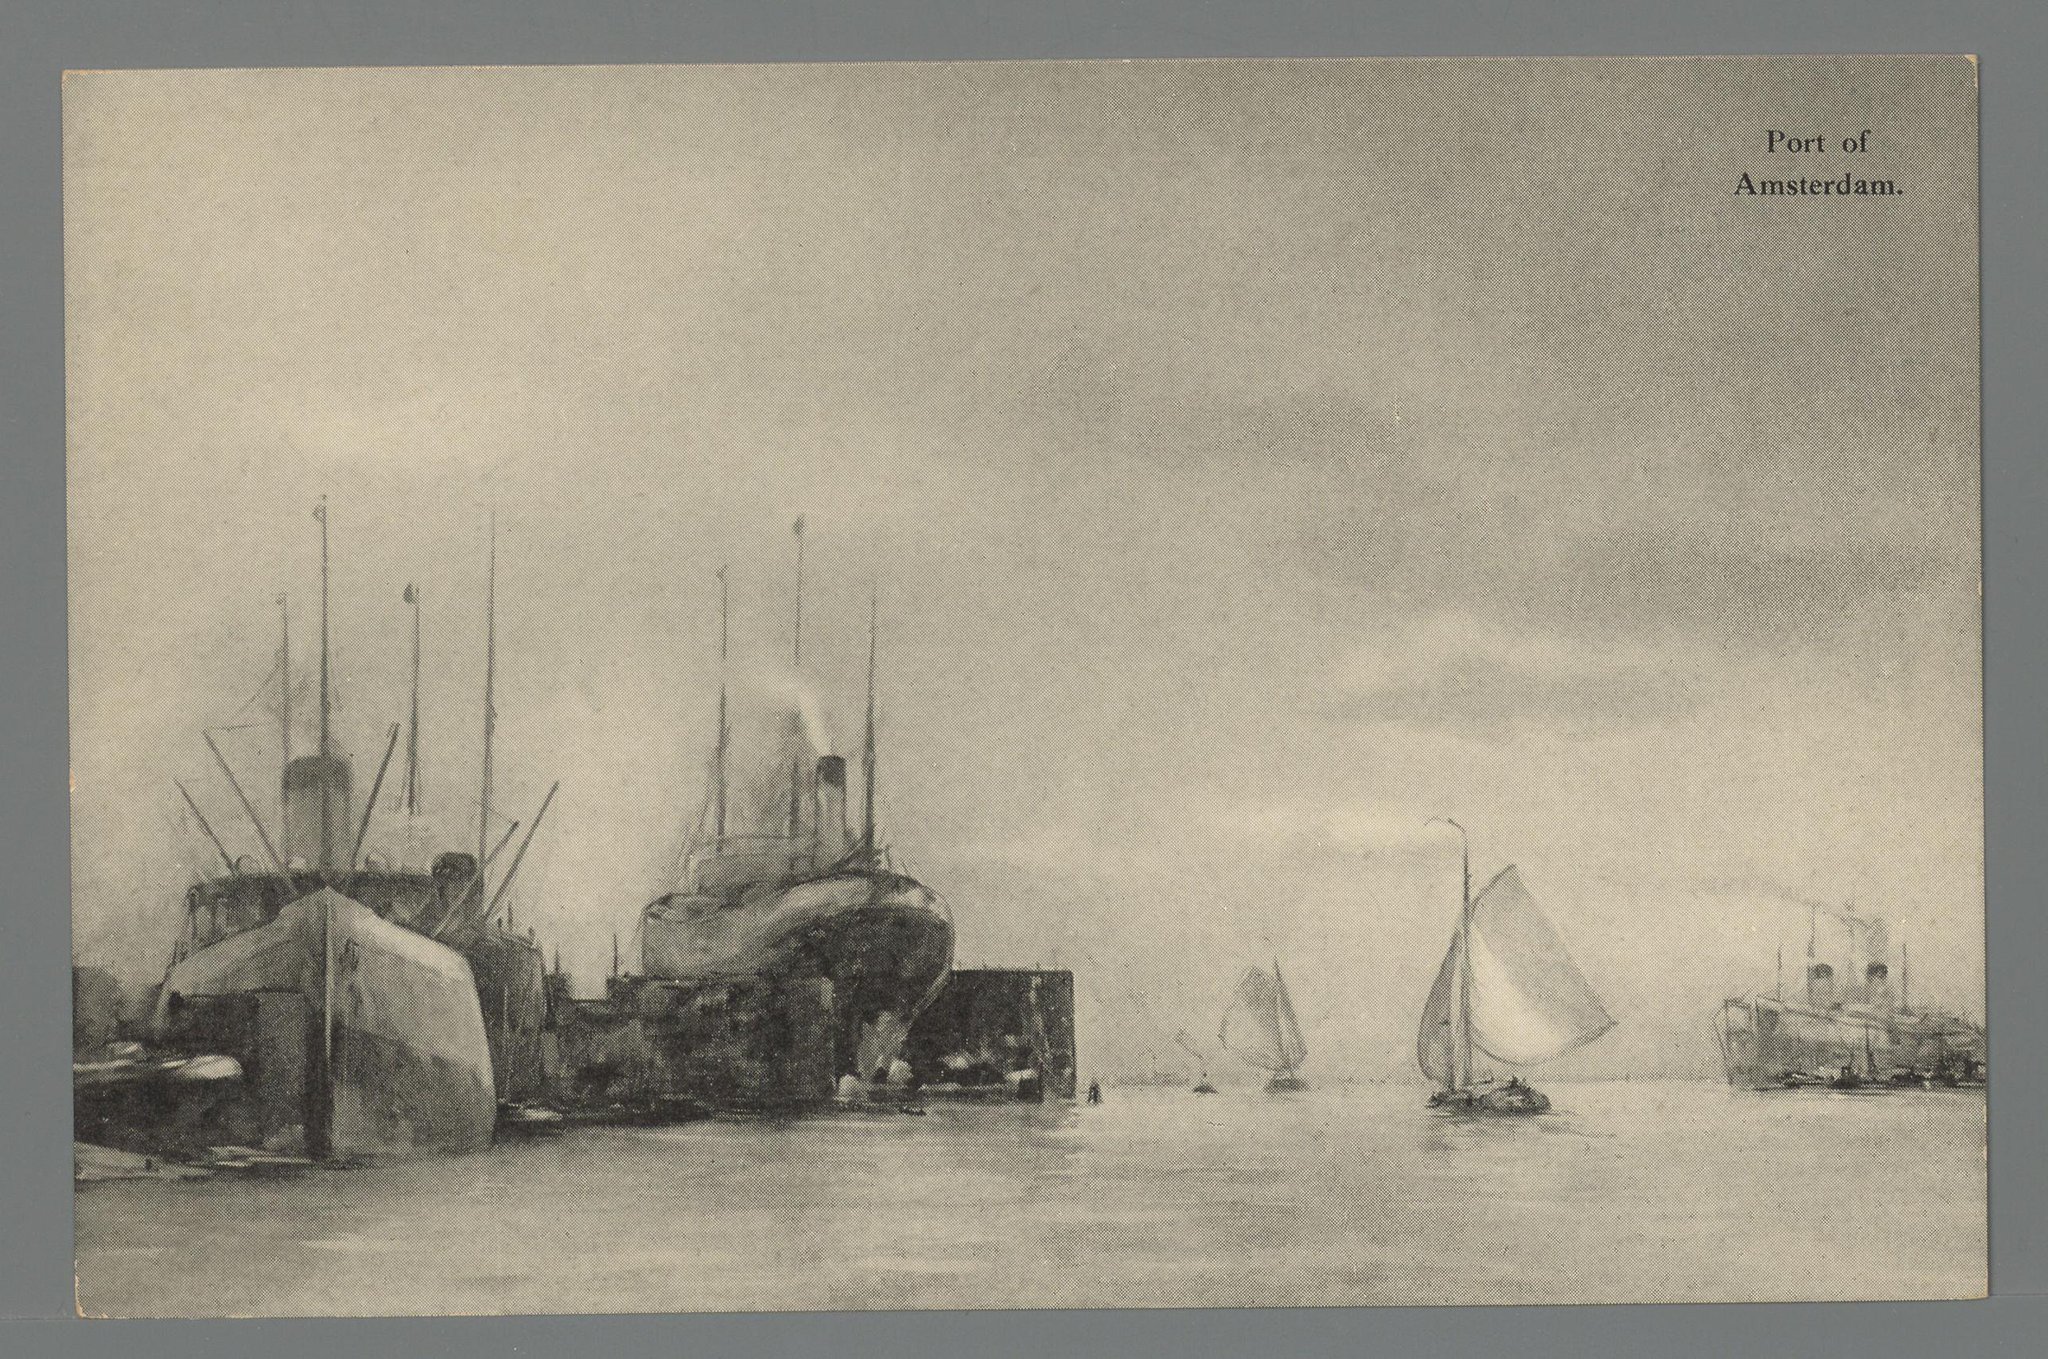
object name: ansichtkaart, prentbriefkaart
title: Reproductie van: Port of Amsterdam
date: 1912-1930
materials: cardboard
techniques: autotype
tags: harbour, sailing-ship, sailing-boat, steamship, motorship, port of amsterdam